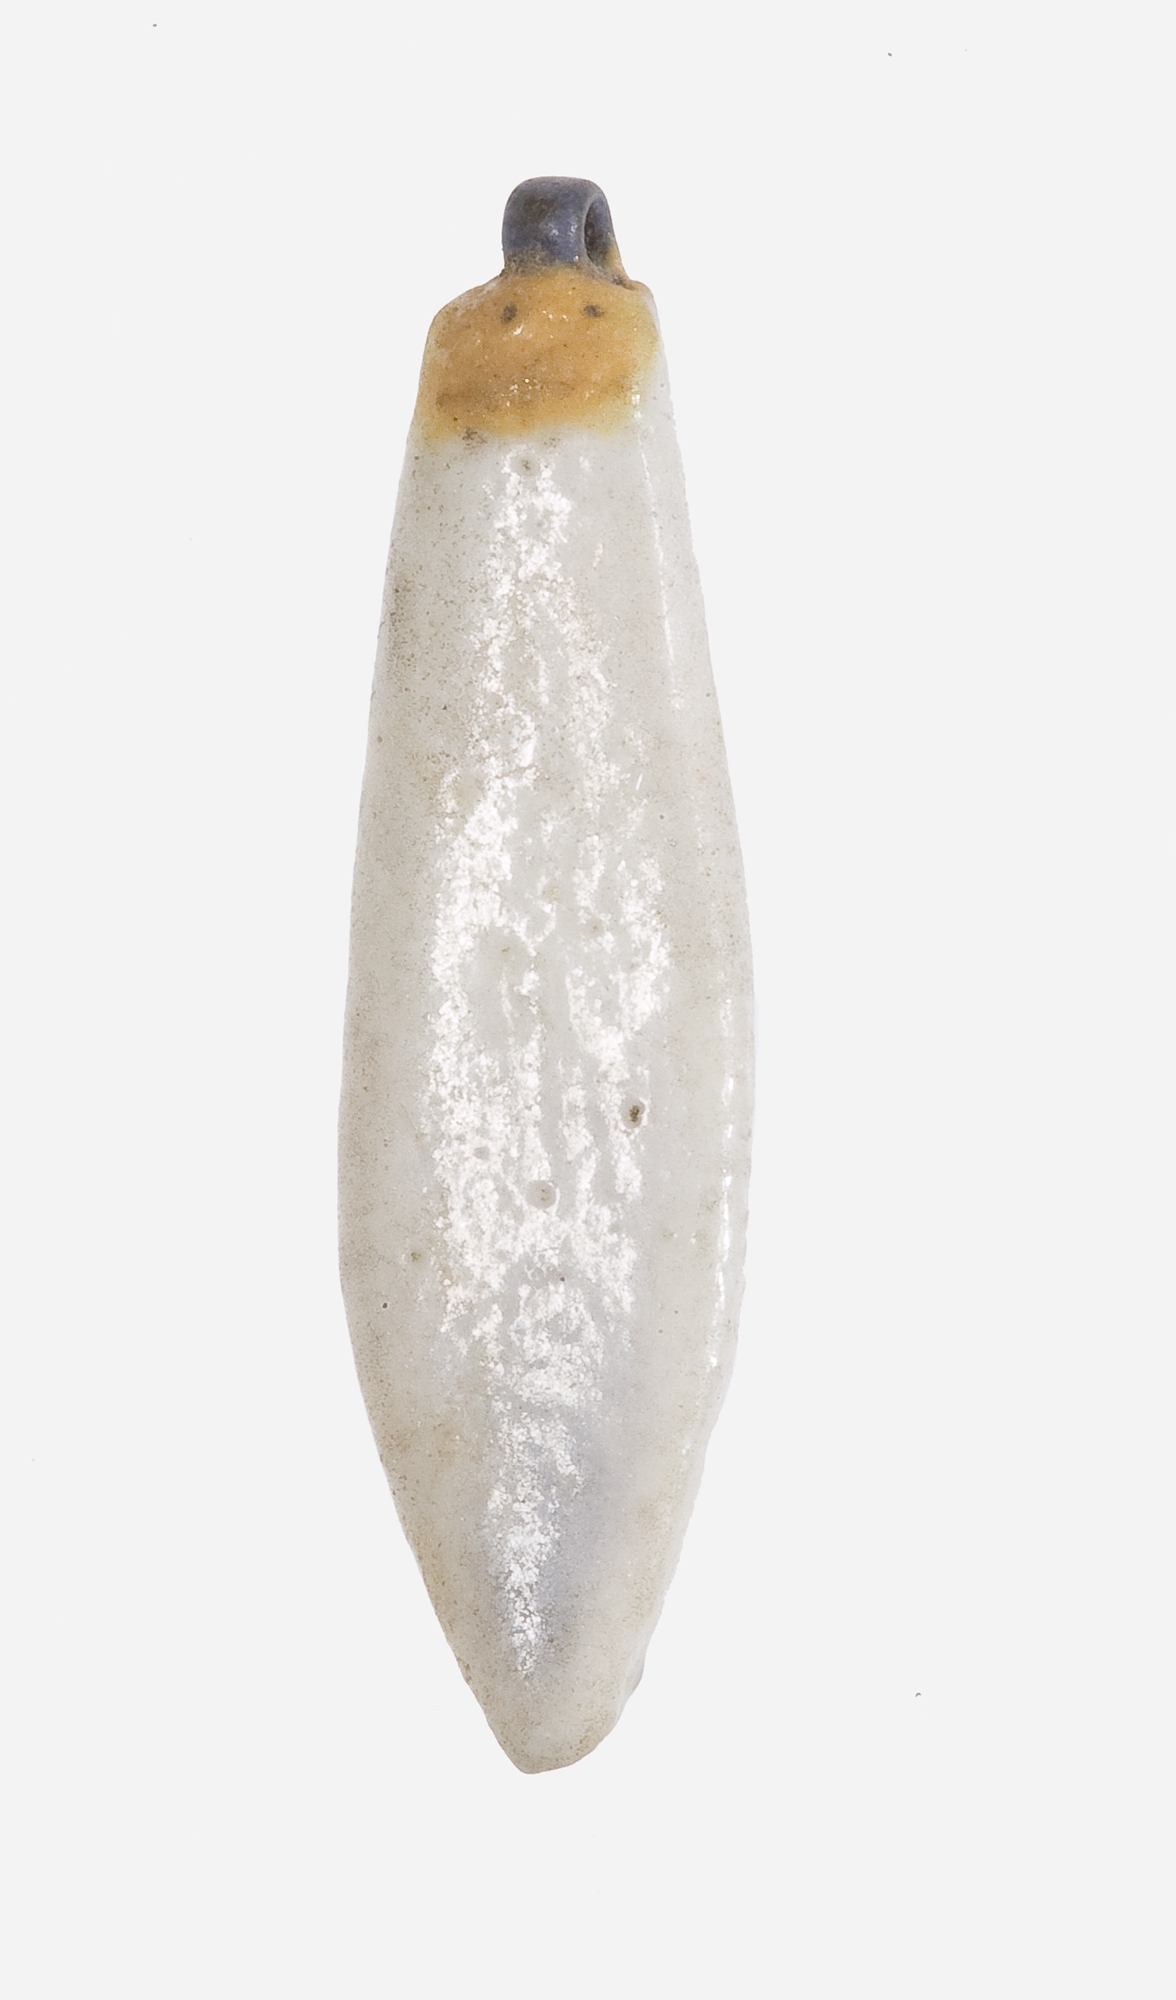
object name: pendant, lotus petal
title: Lotus Petal Pendant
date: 1390-1352 BCE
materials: faience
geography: egypt